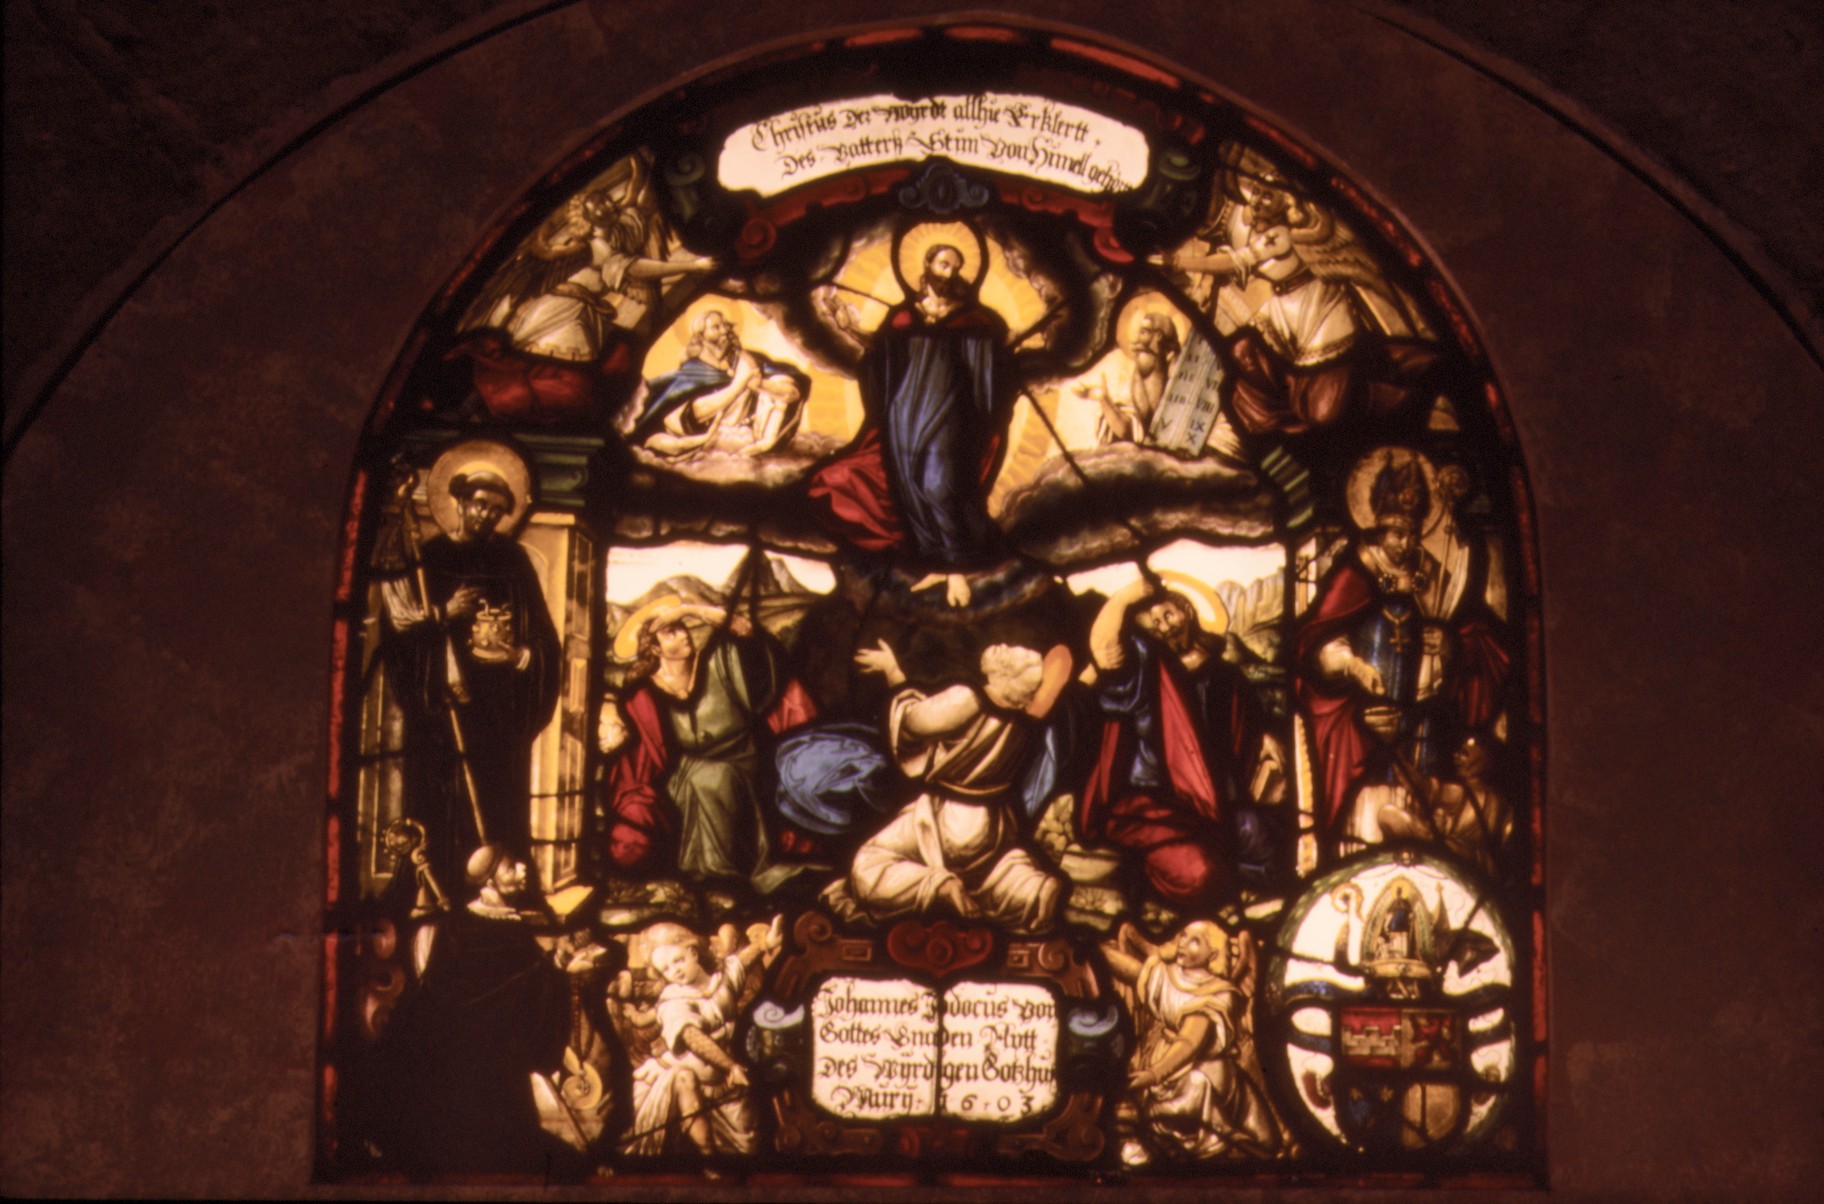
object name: panel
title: The Transfiguration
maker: franz fallenter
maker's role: artist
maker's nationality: german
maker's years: 1550-1616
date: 1603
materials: glass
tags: angels,christ,saint john the evangelist,moses,saints